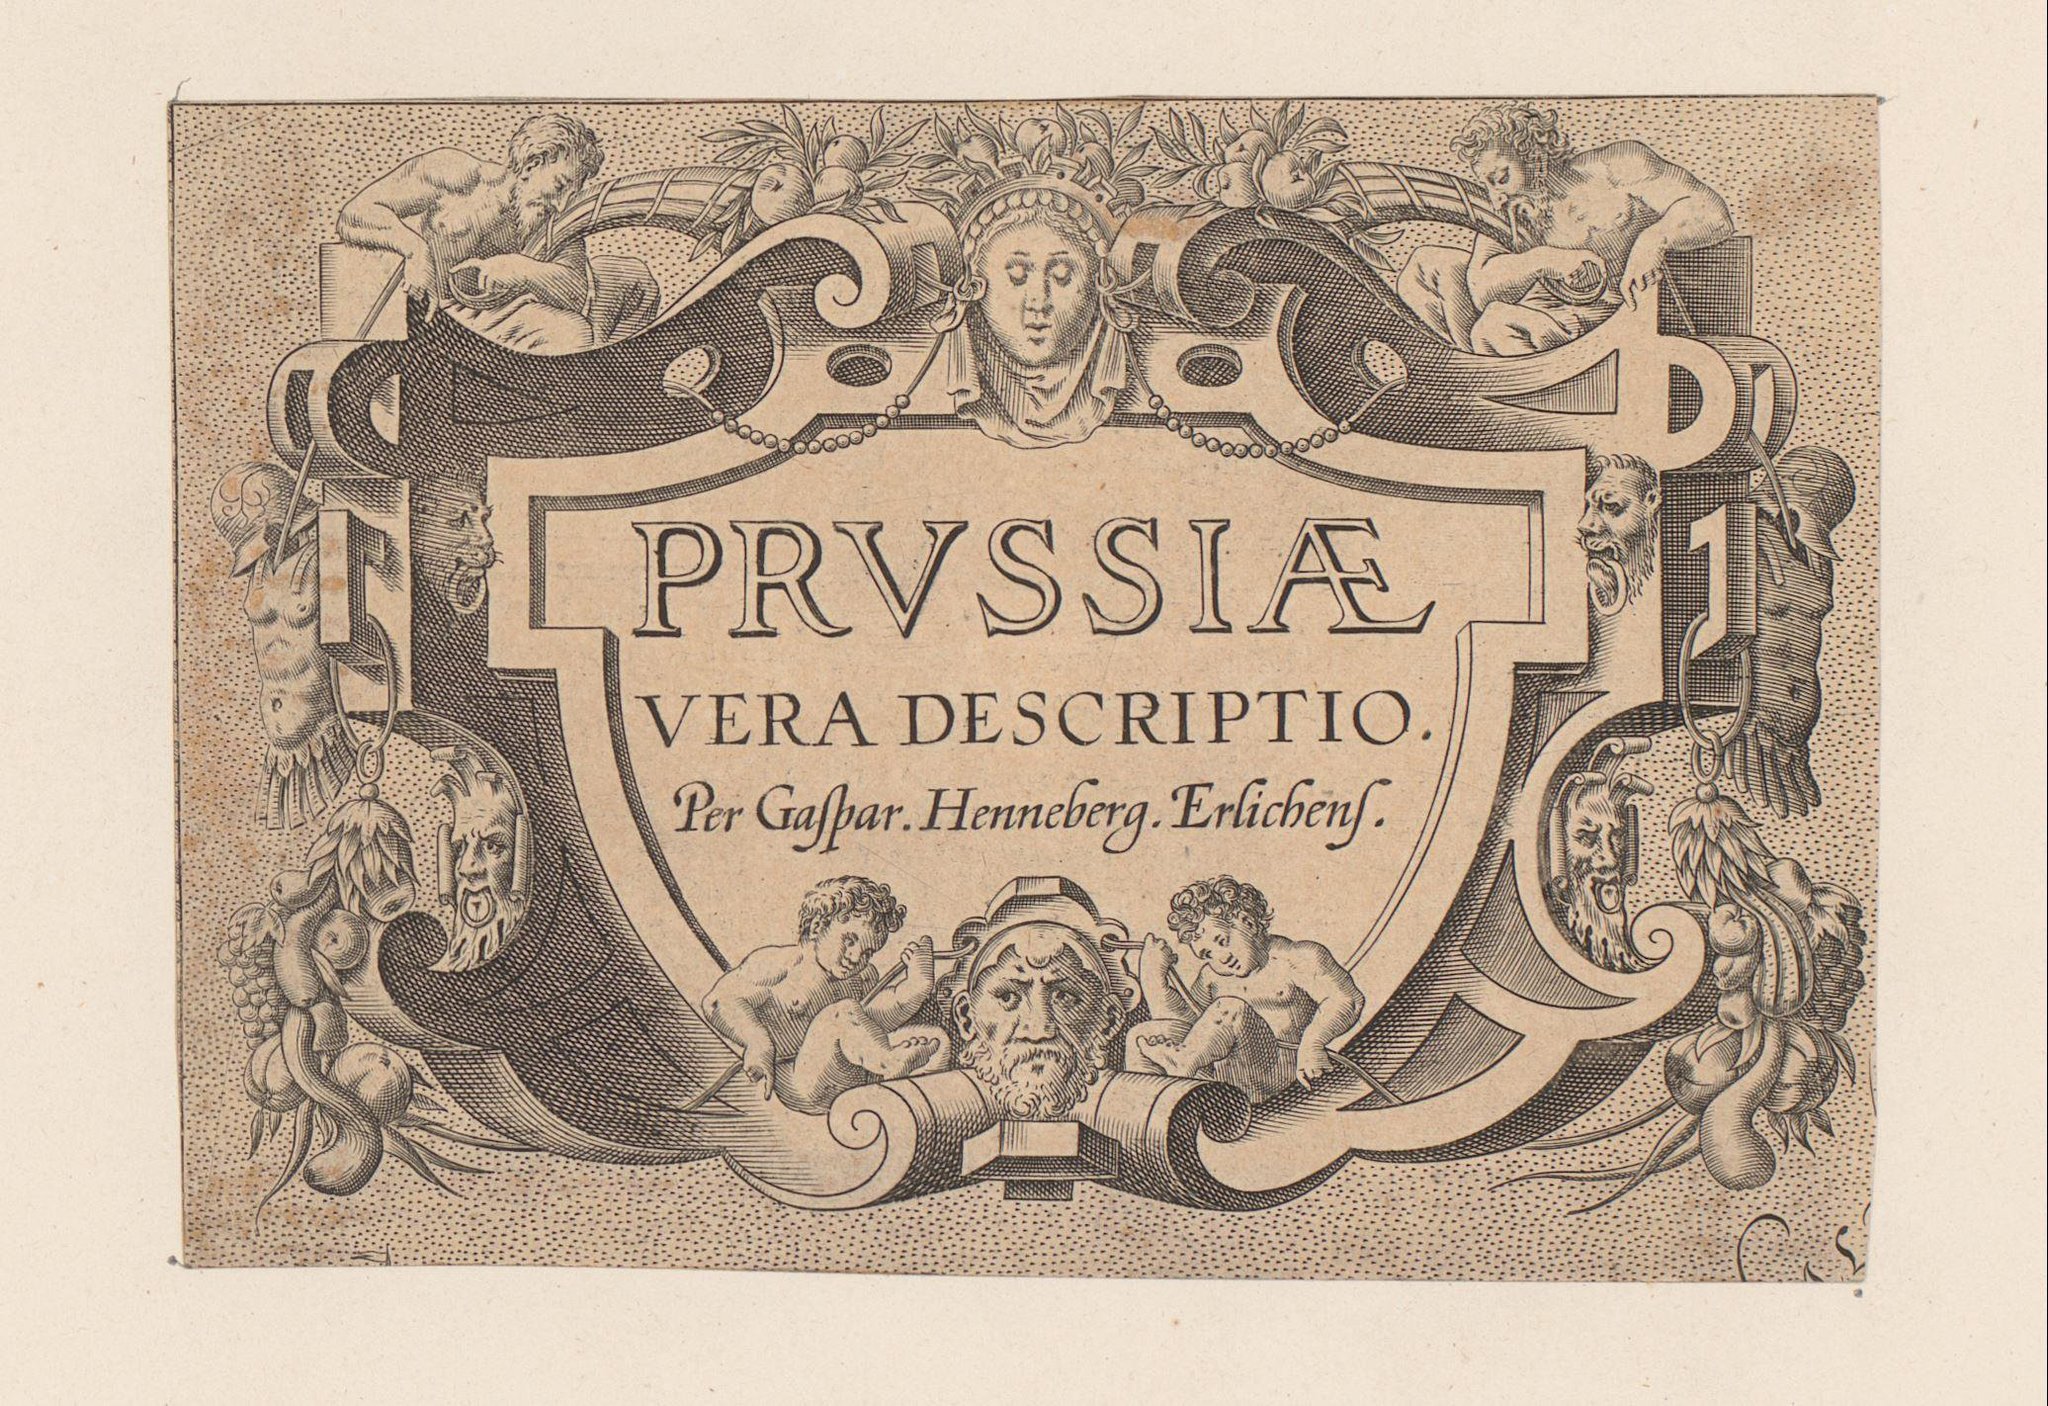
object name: print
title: Prussiae Vera Descriptio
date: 1595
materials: paper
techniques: engraving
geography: antwerp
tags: 'cornucopia', horn of plenty, ornament ~ cartouche, mask, mascaron ~ ornament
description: Cartouche met bovenaan twee mannen met een hoorn des overvloeds (cornucopia). Links en rechts trossen fruit, mascarons en een harnas. Onderaan een vrouwenmasker geflankeerd door twee putti. De cartouche is een fragment van een kaart van Pruisen. De prent maakt deel uit van een album.